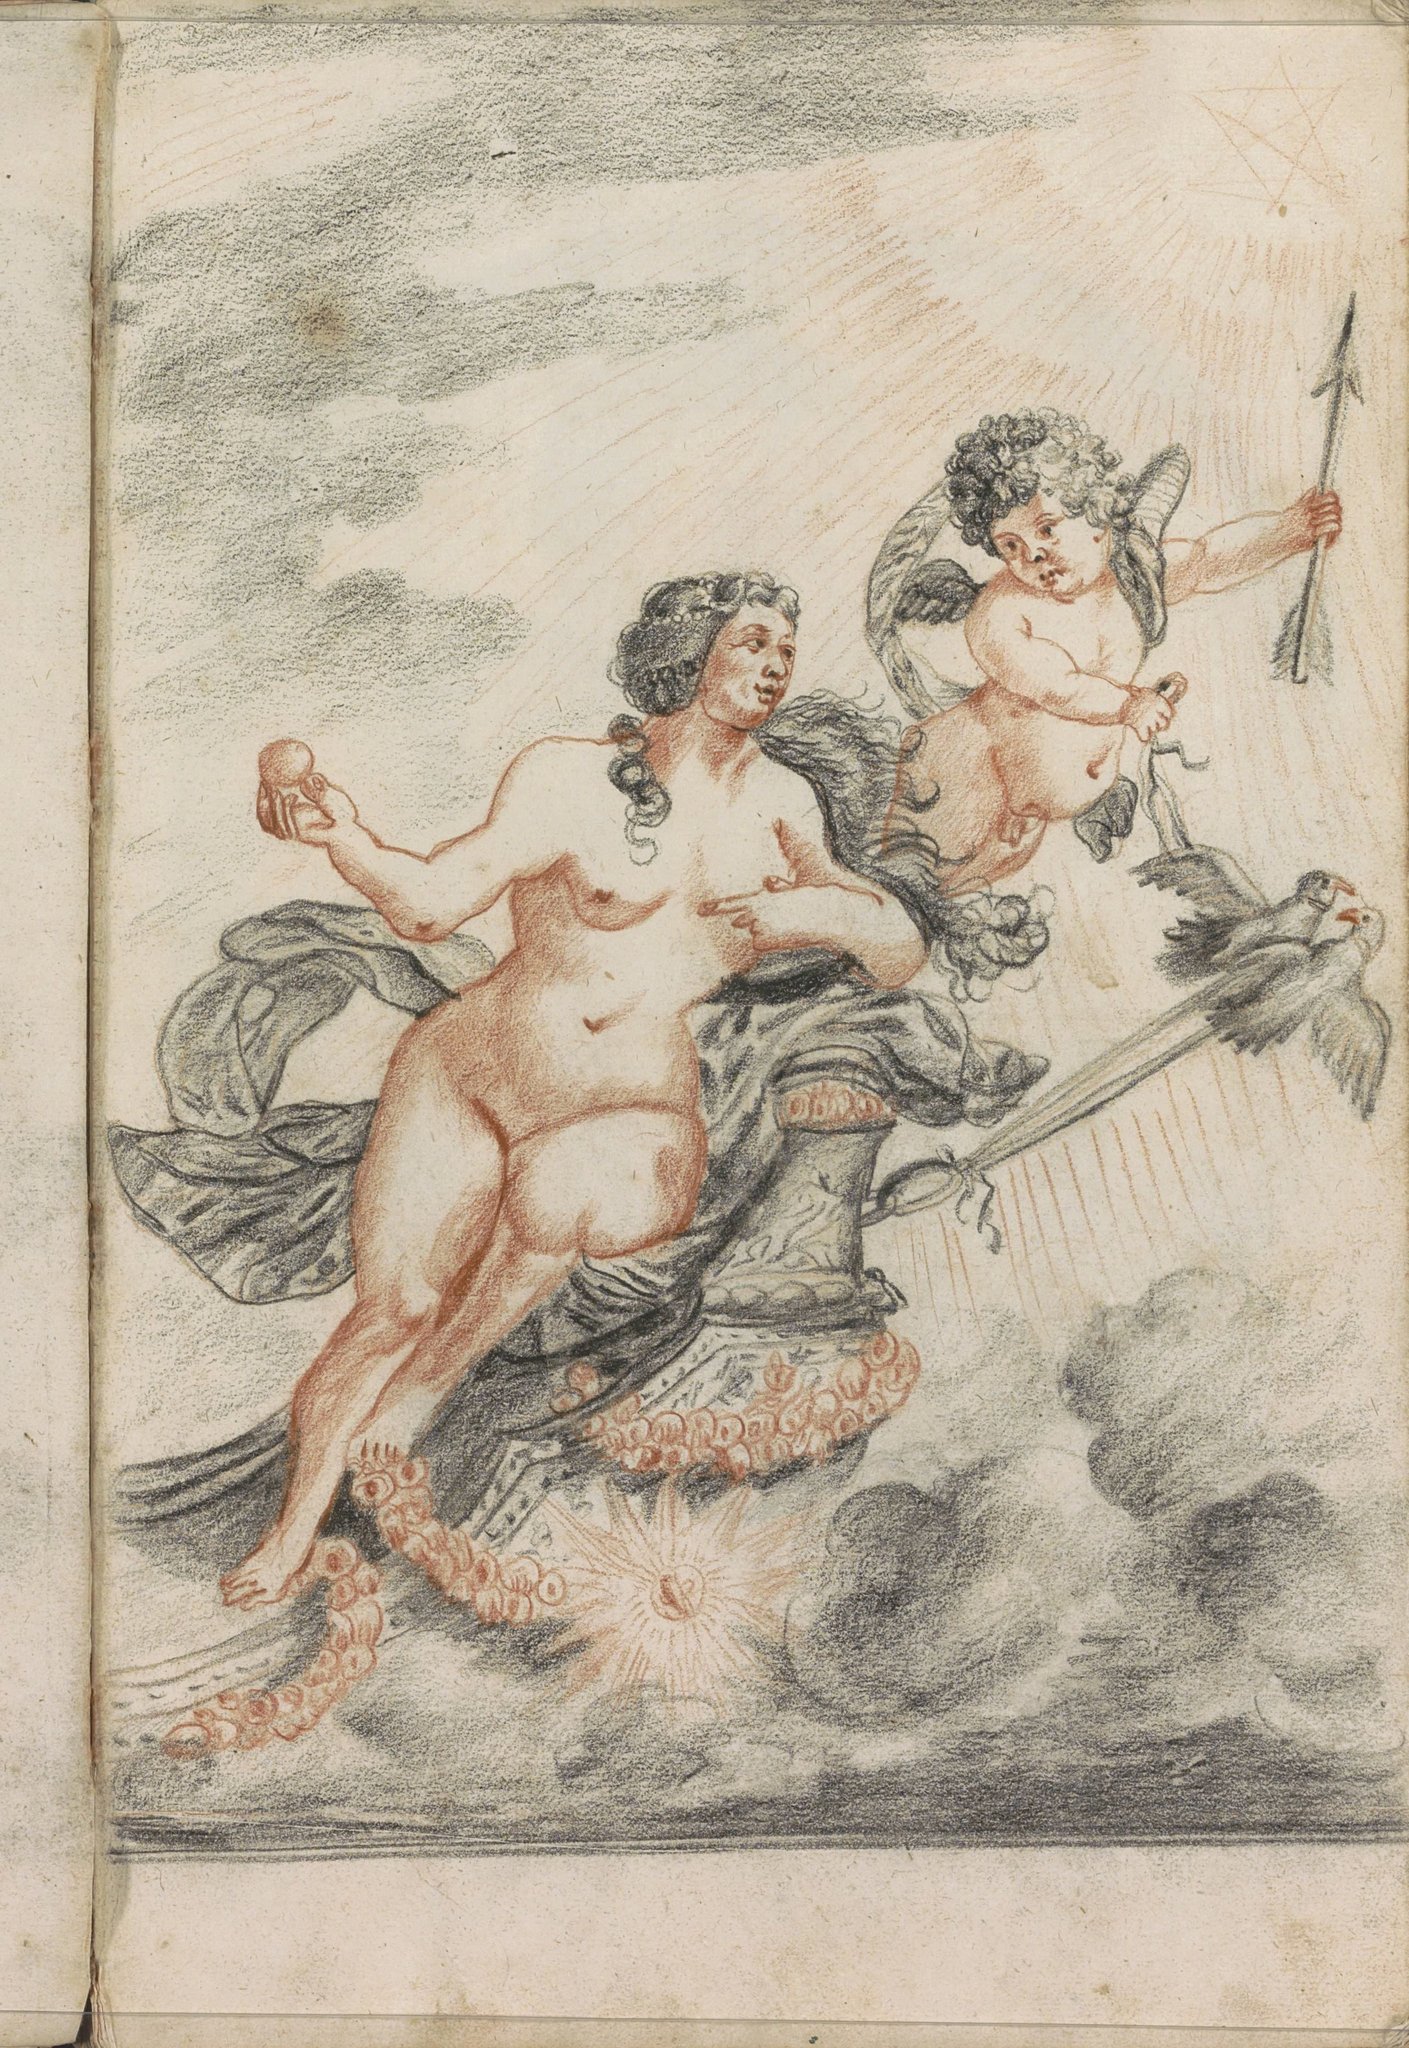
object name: sketchbook leaf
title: Triomf van Venus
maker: hendrick van beaumont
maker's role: draughtsman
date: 1696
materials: chalk, paper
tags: triumph of venus; 'carro di venere' (ripa)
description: Venus op haar zegekar getrokken door twee duiven met Amor die met haar meevliegt. Blad 10 recto uit een schetsboek met 91 bladen.